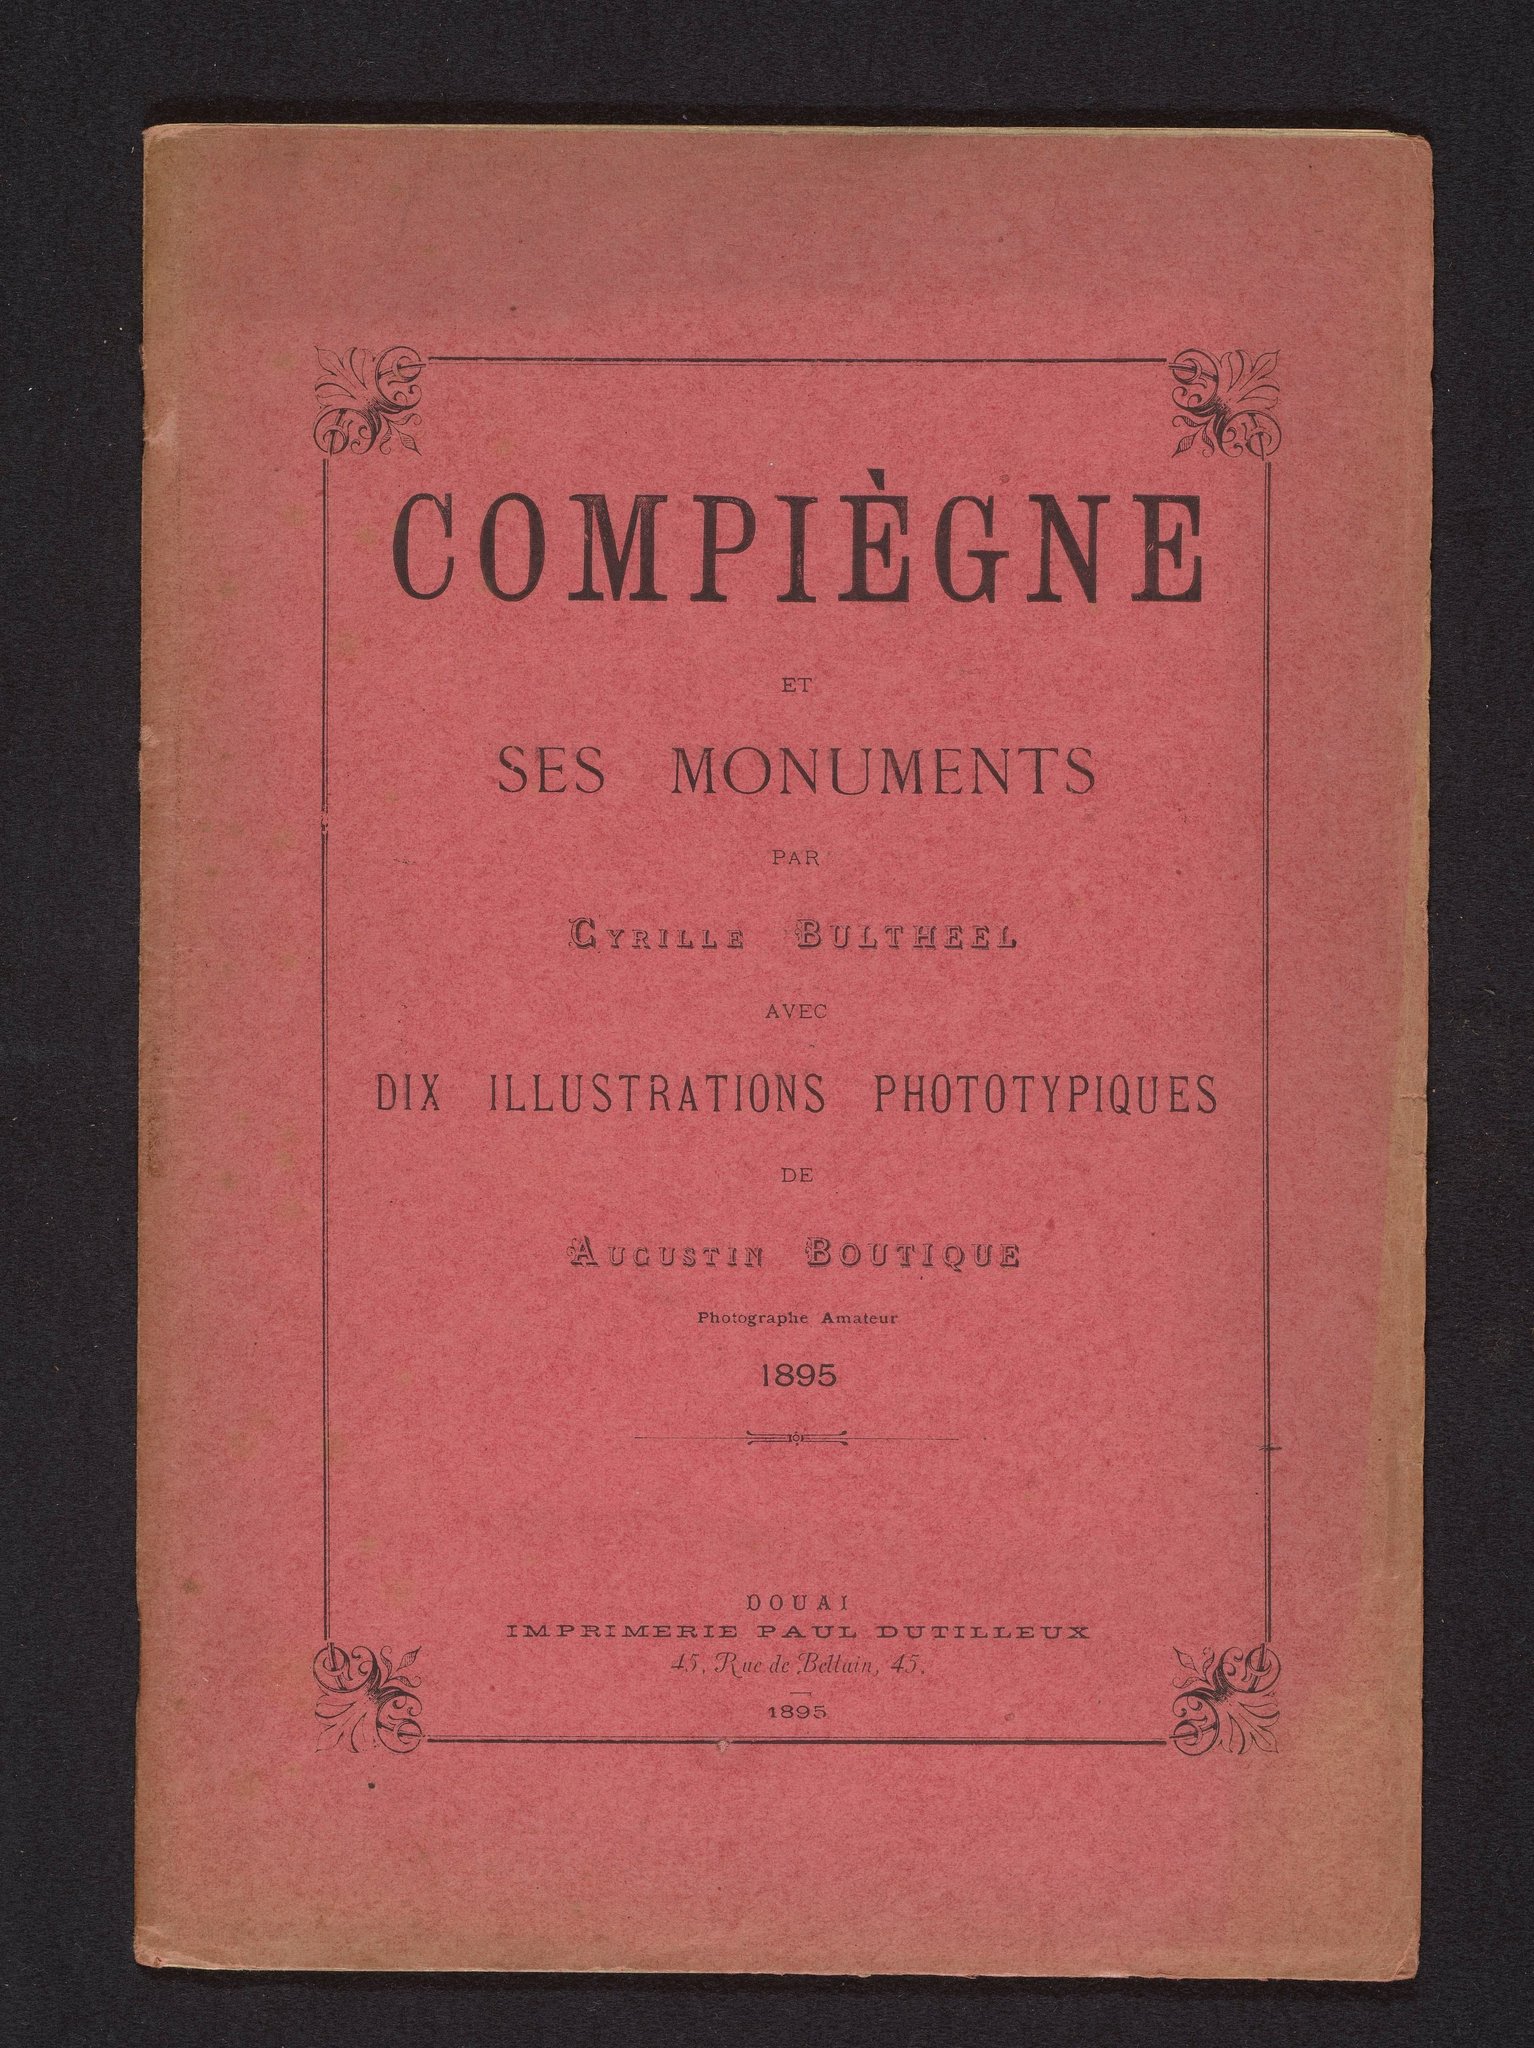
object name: book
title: Compiègne et ses monuments / par Cyrille Bultheel; avec dix ill. phototypiques de Augustin Boutique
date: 1895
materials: paper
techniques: photograph, printing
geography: douai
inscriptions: date: ‘DEC/ 2009’